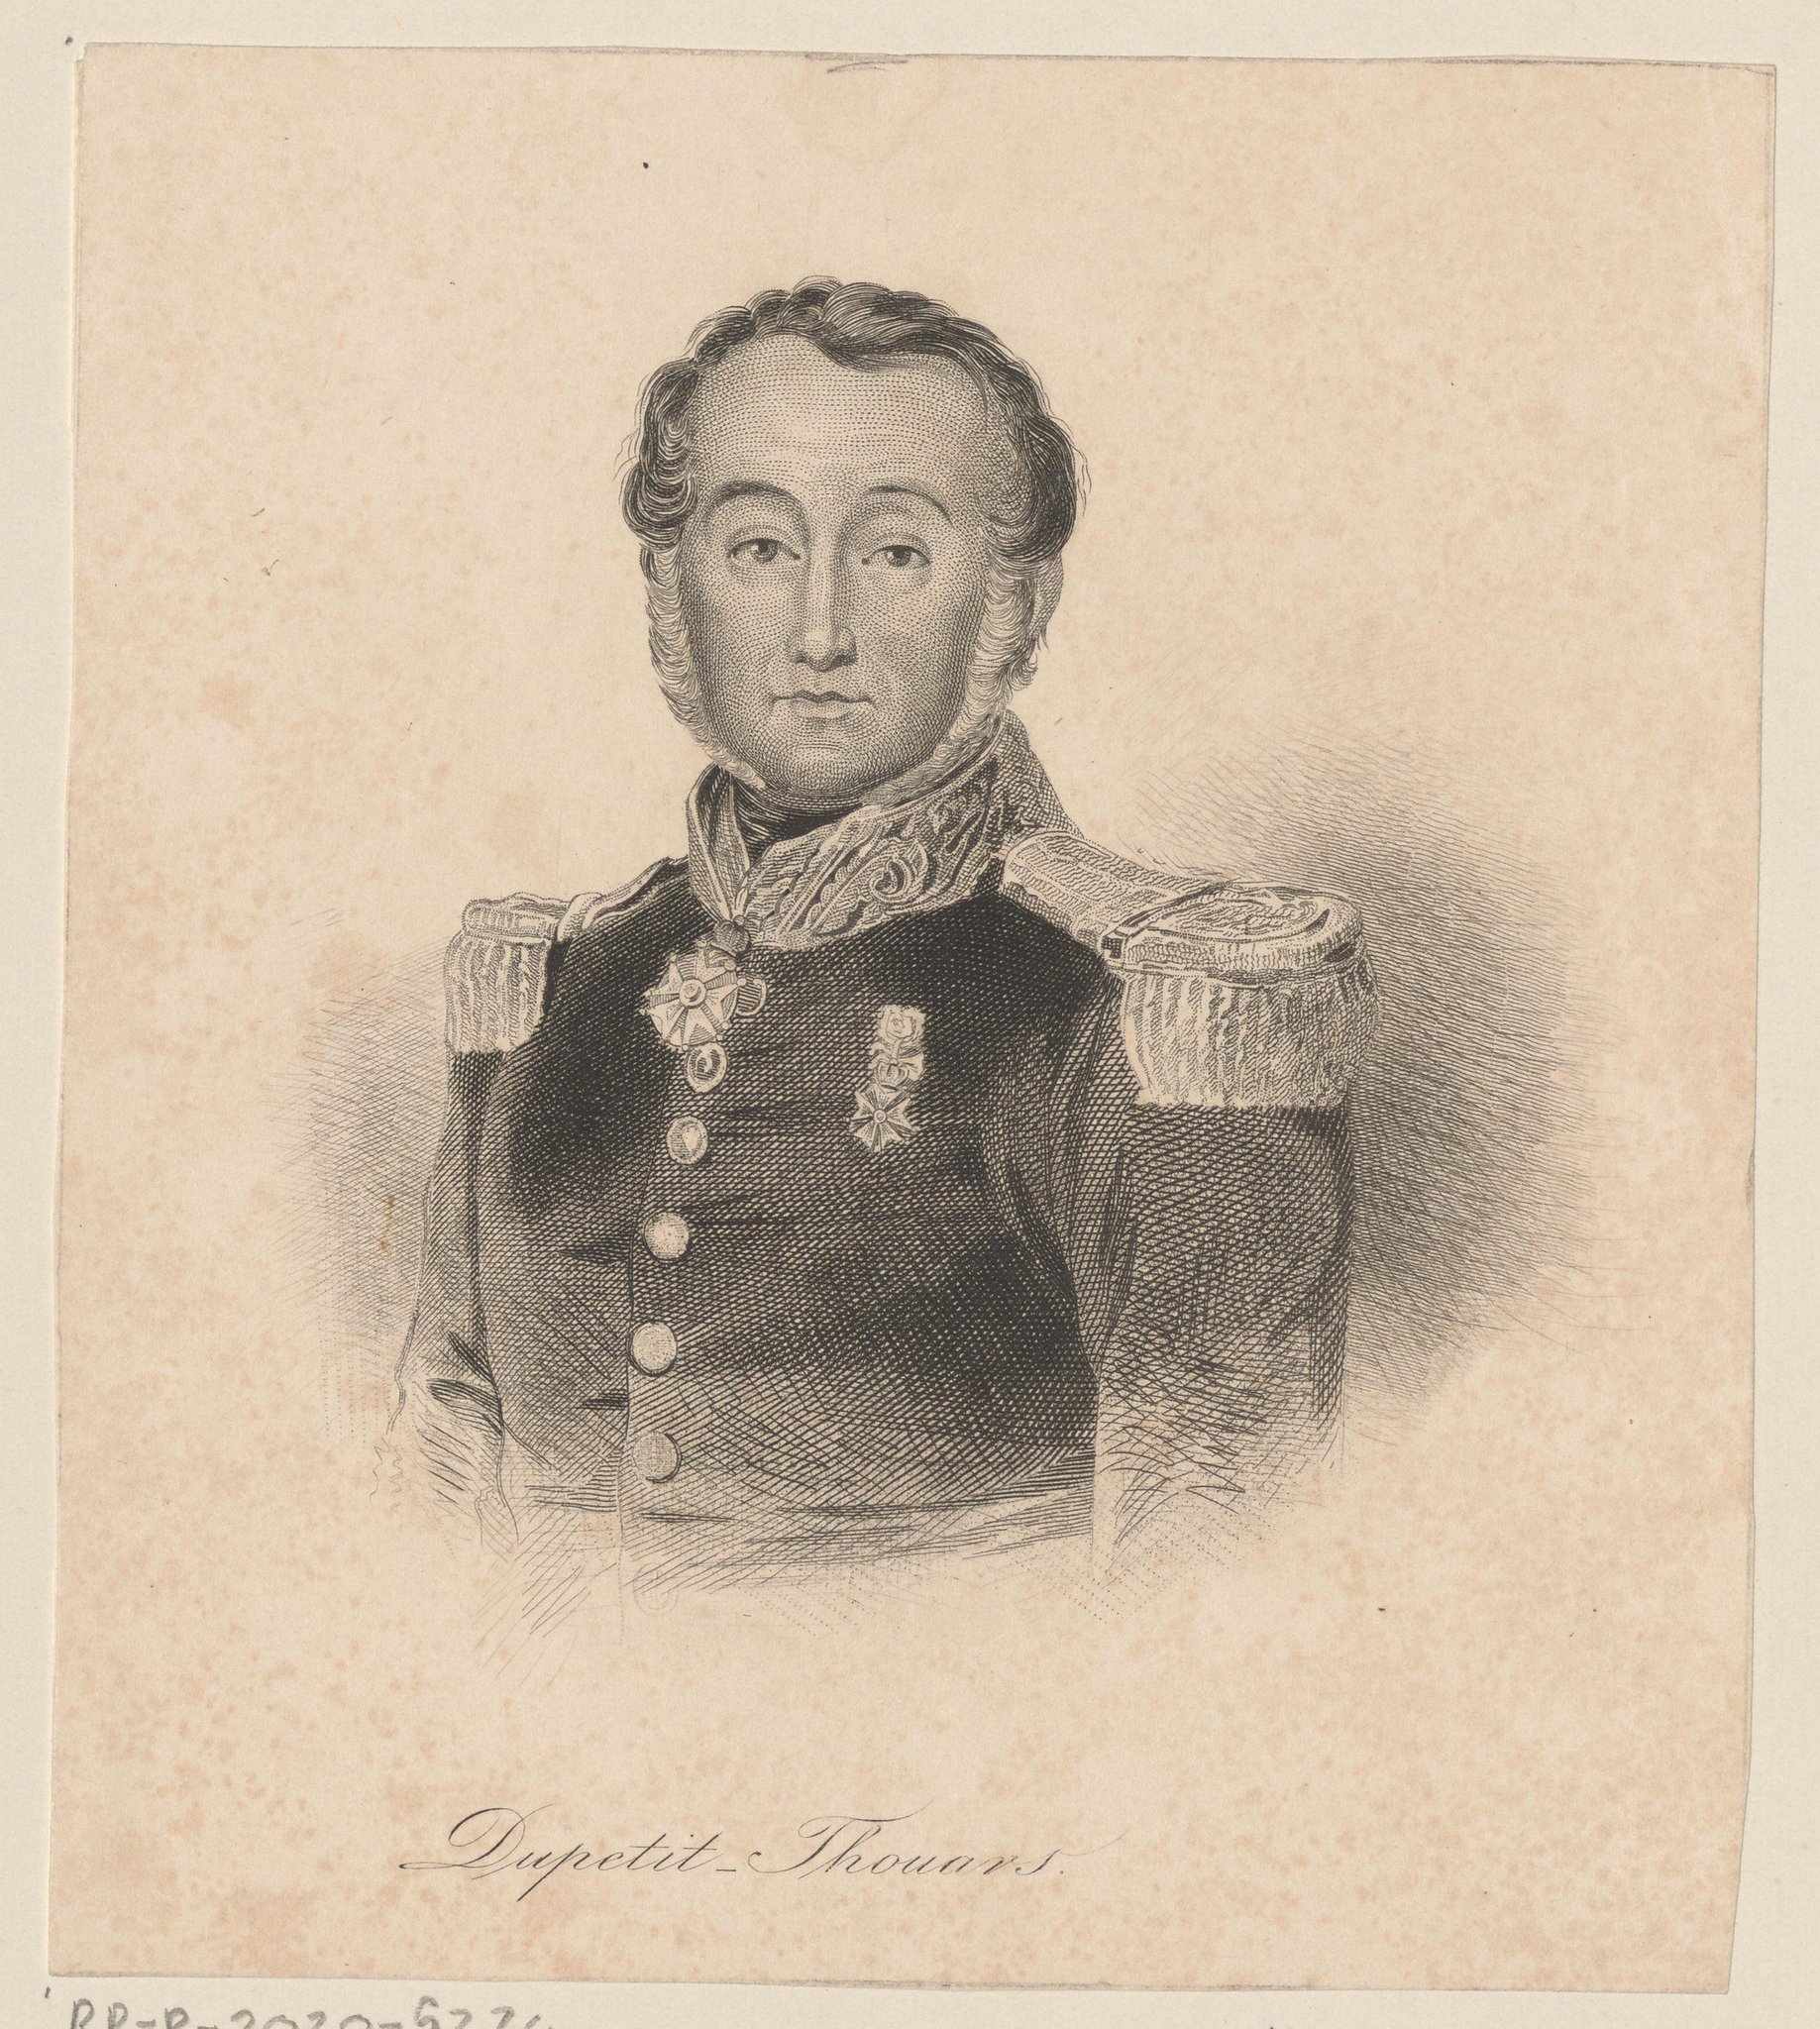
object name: print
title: Portret van Abel Aubert du Petit-Thouars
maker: andrew duncan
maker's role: print maker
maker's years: 1795-1855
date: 1826-1855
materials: paper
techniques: engraving, etching, roulette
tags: historical persons, seaman